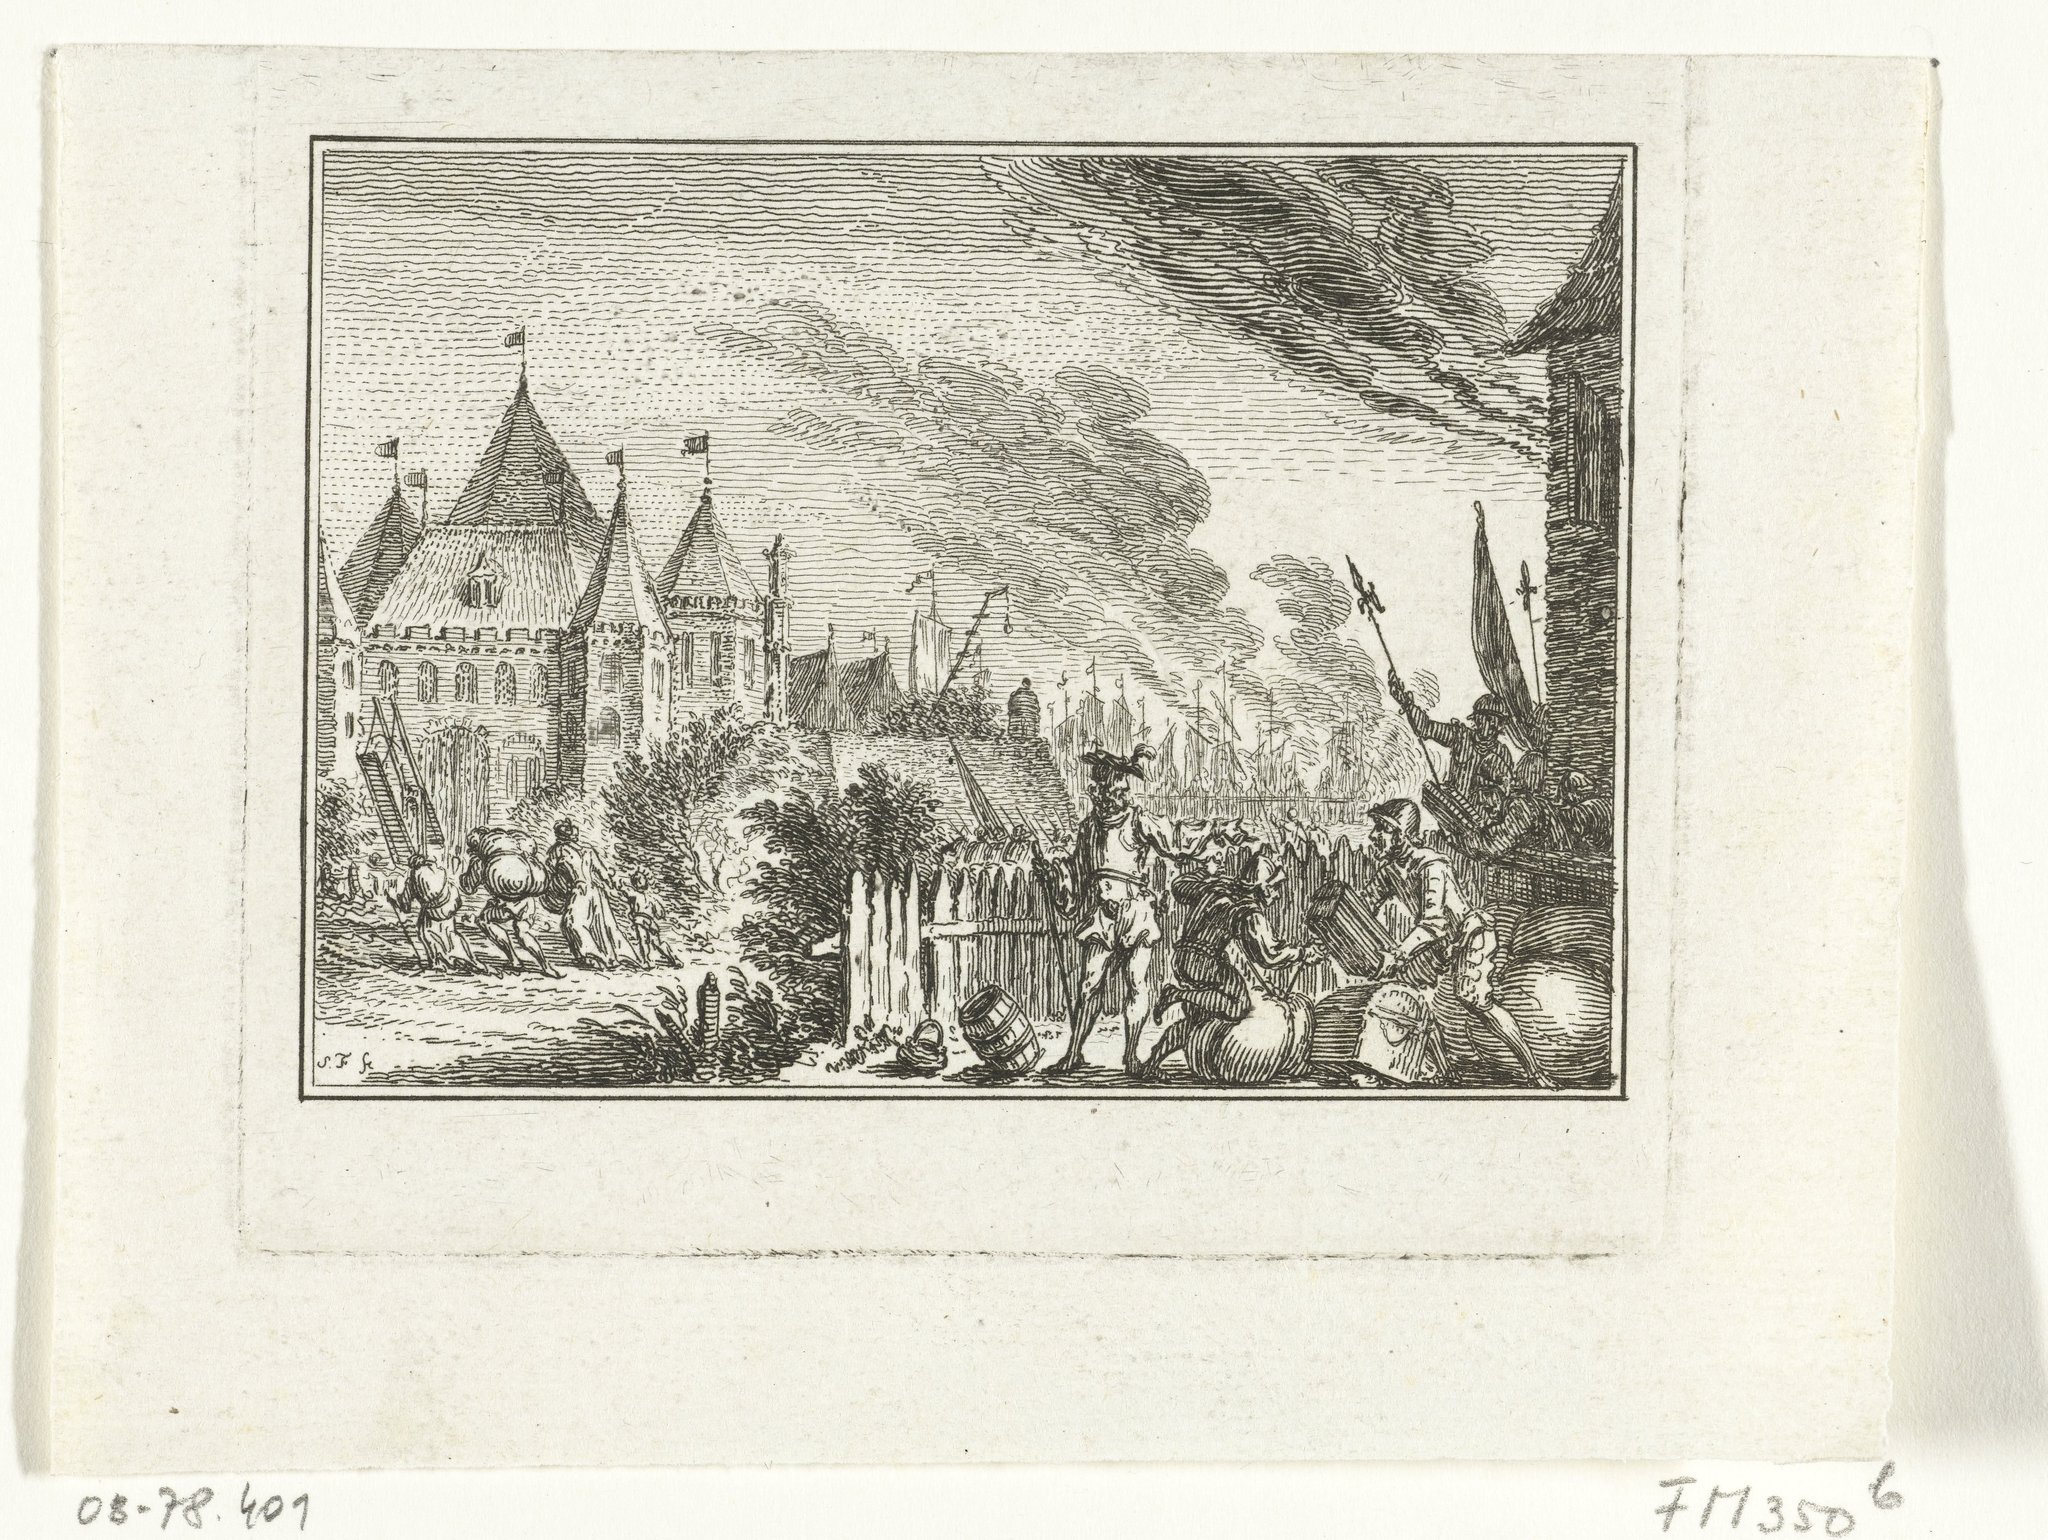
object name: print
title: Troepen Karel van Gelre buiten Amsterdam, 1507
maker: simon fokke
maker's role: draughtsman, print maker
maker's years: 1712-1784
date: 1782-1784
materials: paper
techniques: etching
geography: northern netherlands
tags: arnhem, earl, battle, fighting in general, amsterdam, guelders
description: Illustratie voor: J.W. te Water, De vaderlandsche Historie van den heere J. Wagenaar, verkort, en met leerzaame aanmerkingen, ten dienste der Nederlandsche jeugd, 1784-1800, 4 delen, p. 202, pl. XXX. Staat vóór de letter.